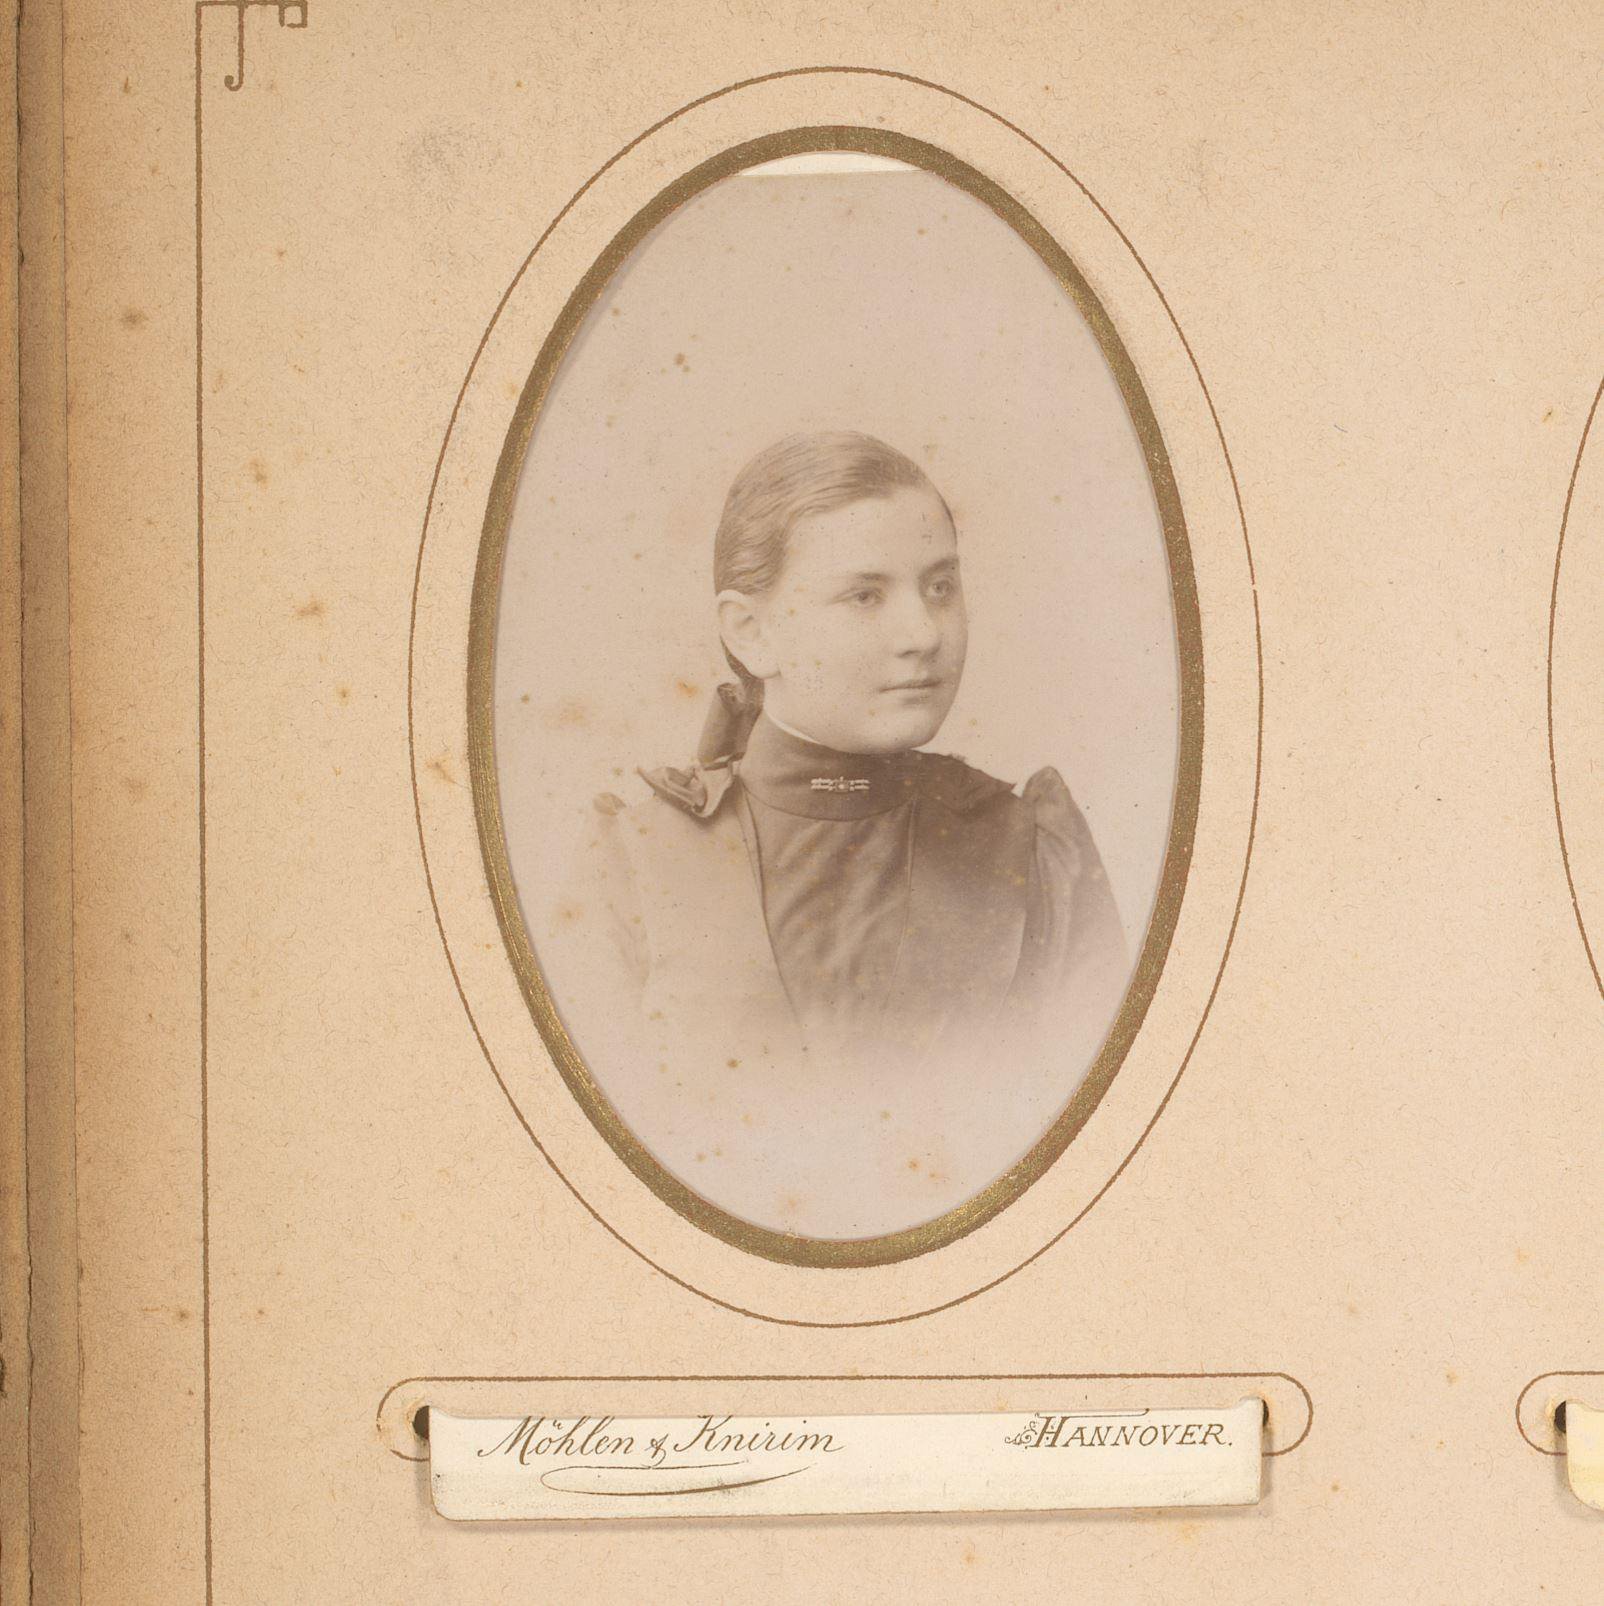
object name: album leaf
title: Portret van een meisje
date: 1880-1900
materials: cardboard, photographic support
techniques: albumen print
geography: hannover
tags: historical persons - bb - woman, girl (child between toddler and youth)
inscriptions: inscription: ‘Möhlen & Knirim/ Hannover’